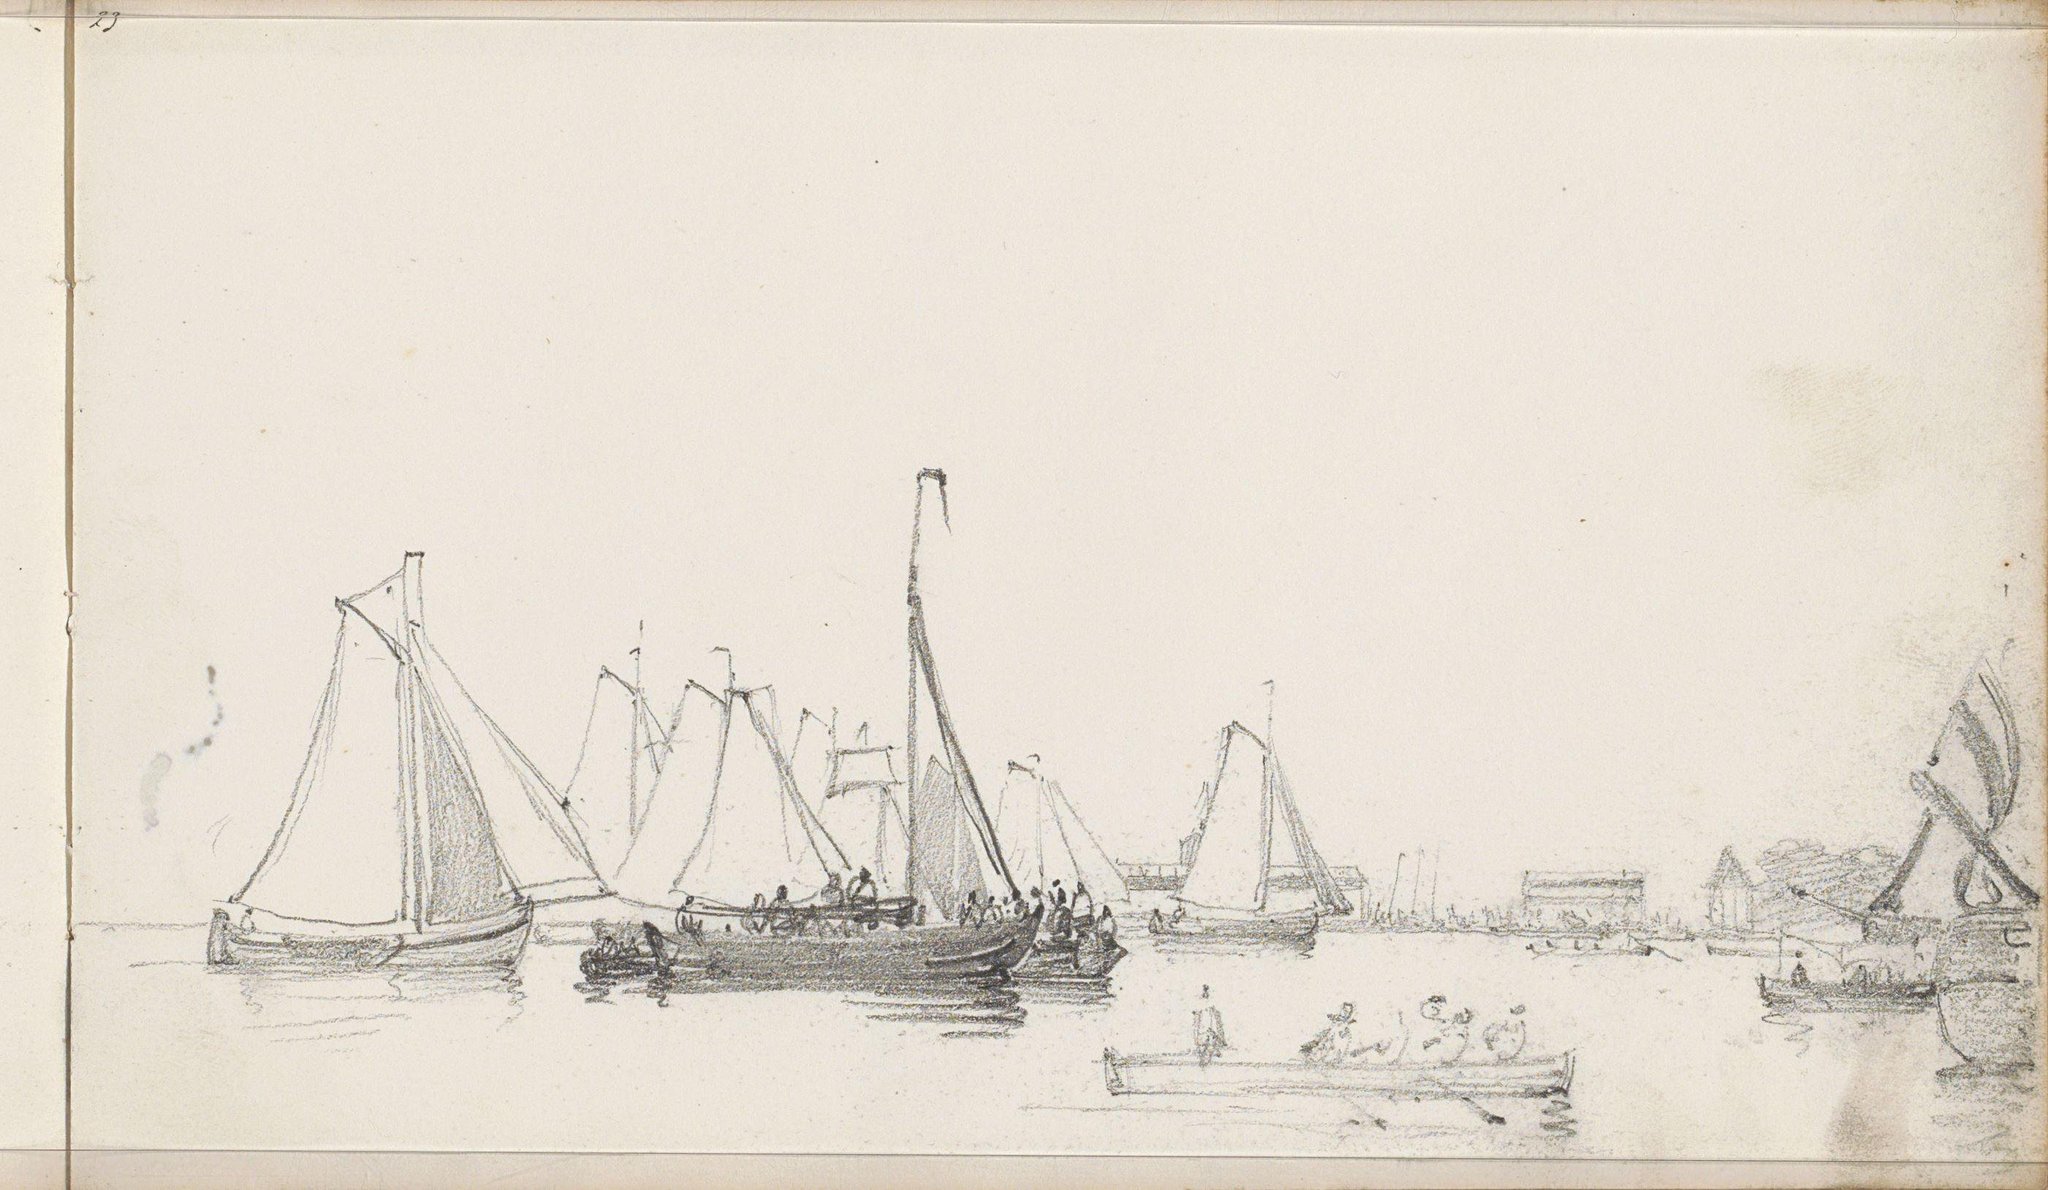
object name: sketchbook leaf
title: Havenscène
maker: petrus johannes schotel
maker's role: draughtsman, painter, print maker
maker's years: 1808-1865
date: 1841-1865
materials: paper, pencil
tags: harbour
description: Pagina 23 uit een schetsboek met 80 pagina's.